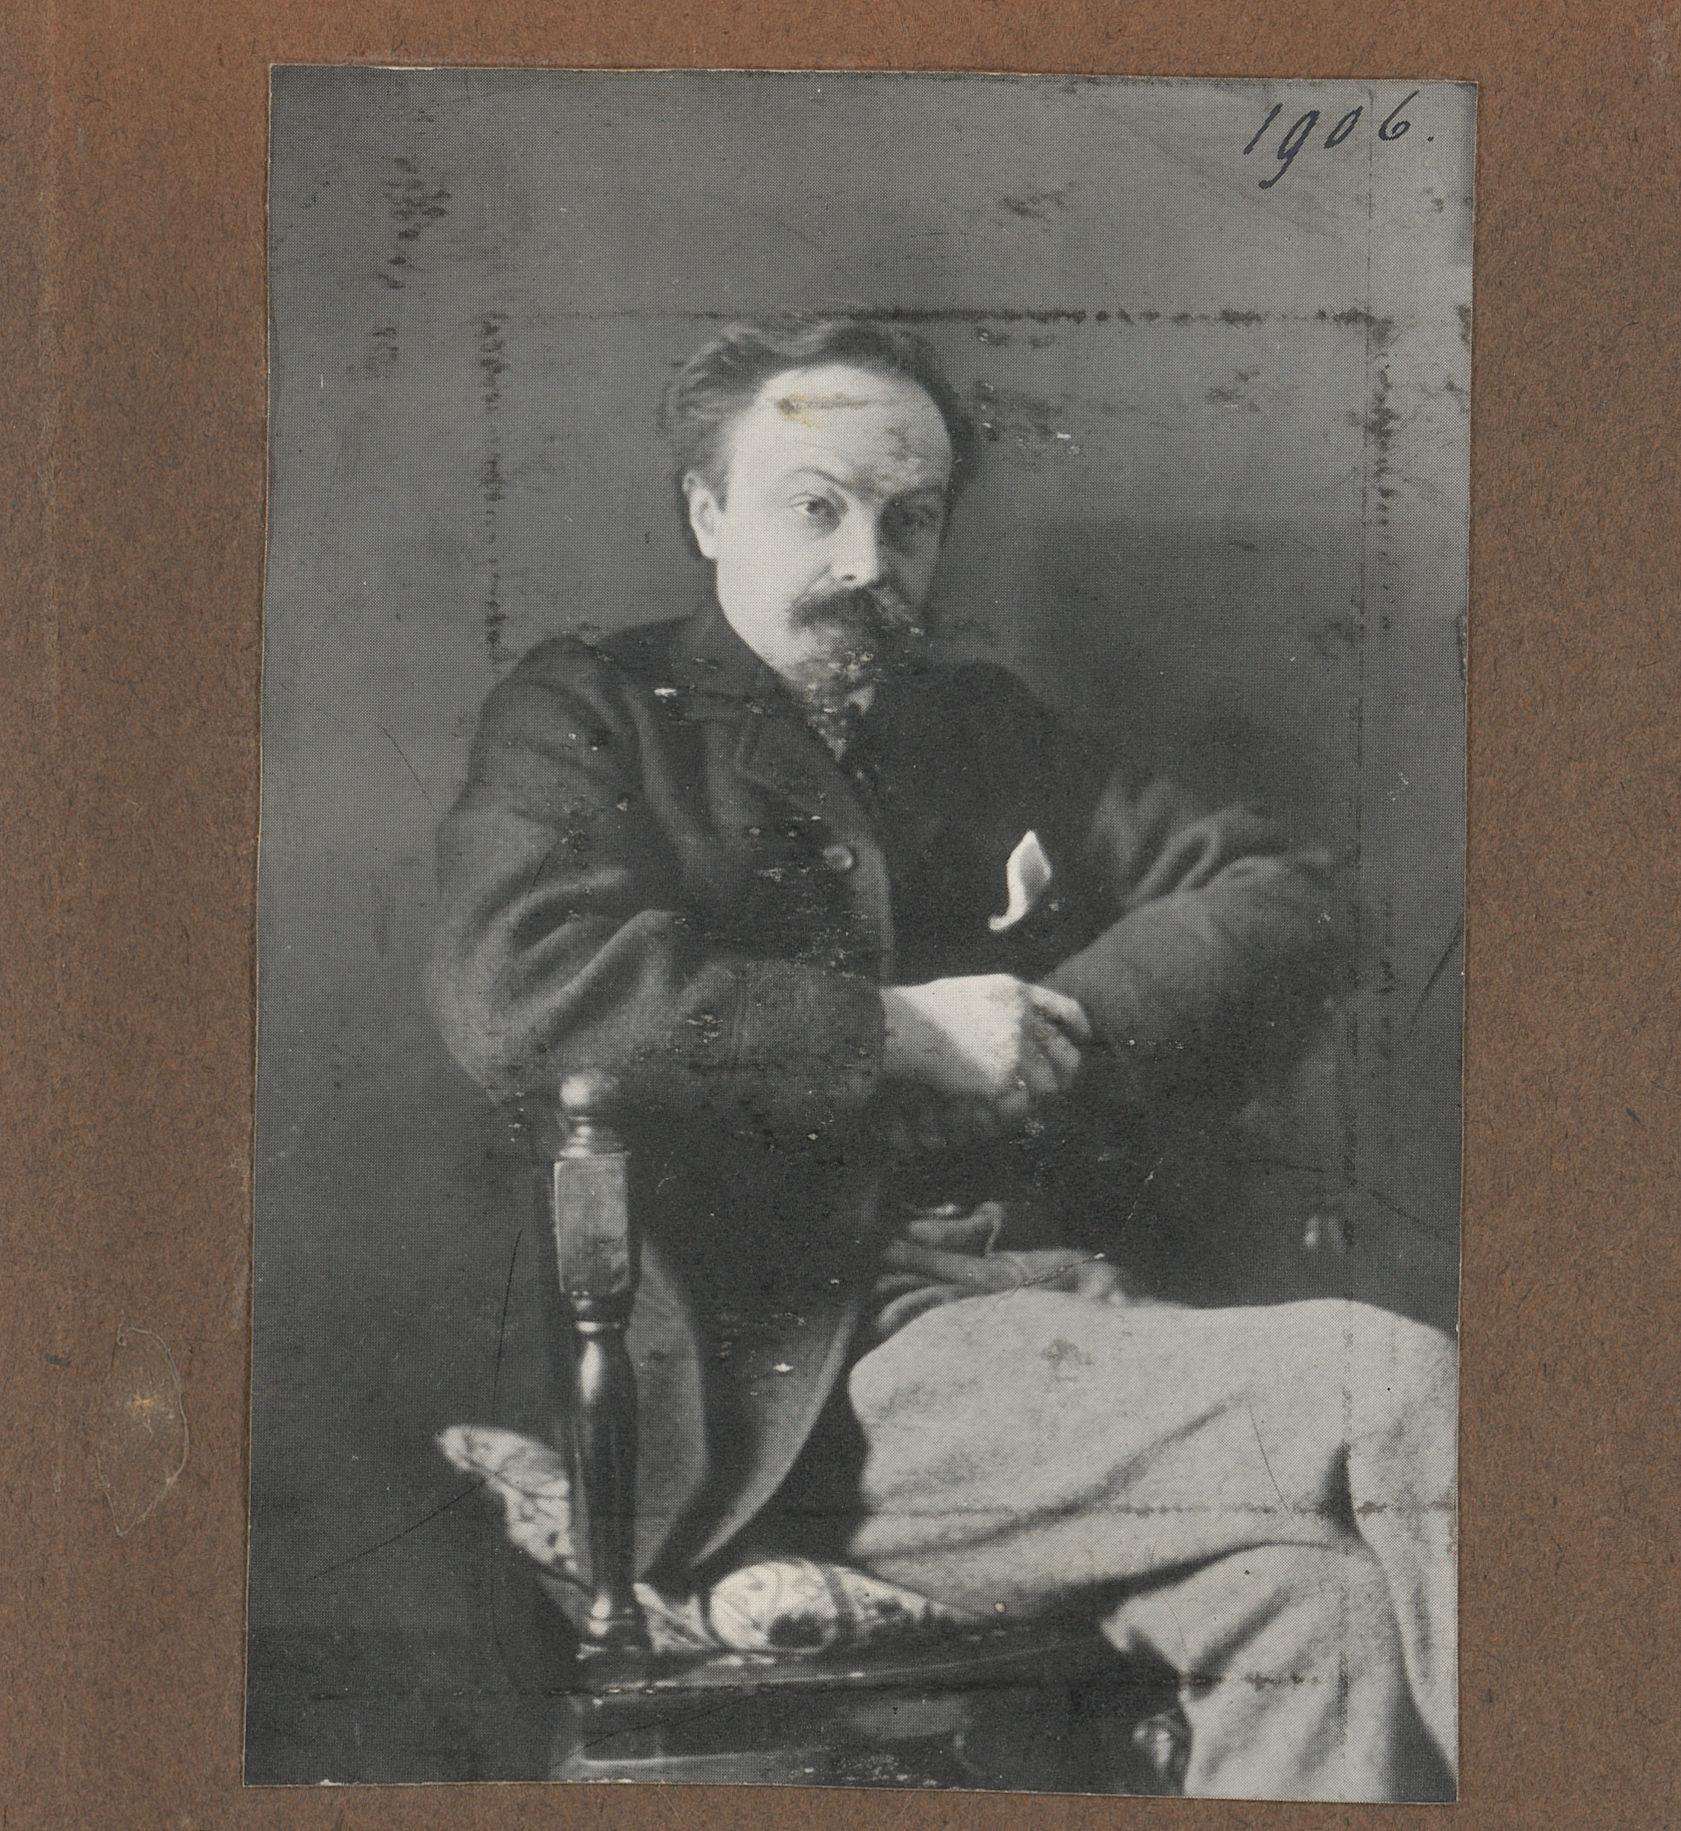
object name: photograph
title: Zittende man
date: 1906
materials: photographic support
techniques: photography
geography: amsterdam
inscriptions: date: ‘1906.’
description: Foto op bruin albumblad 13 van familiealbum van Alphons Diepenbrock.